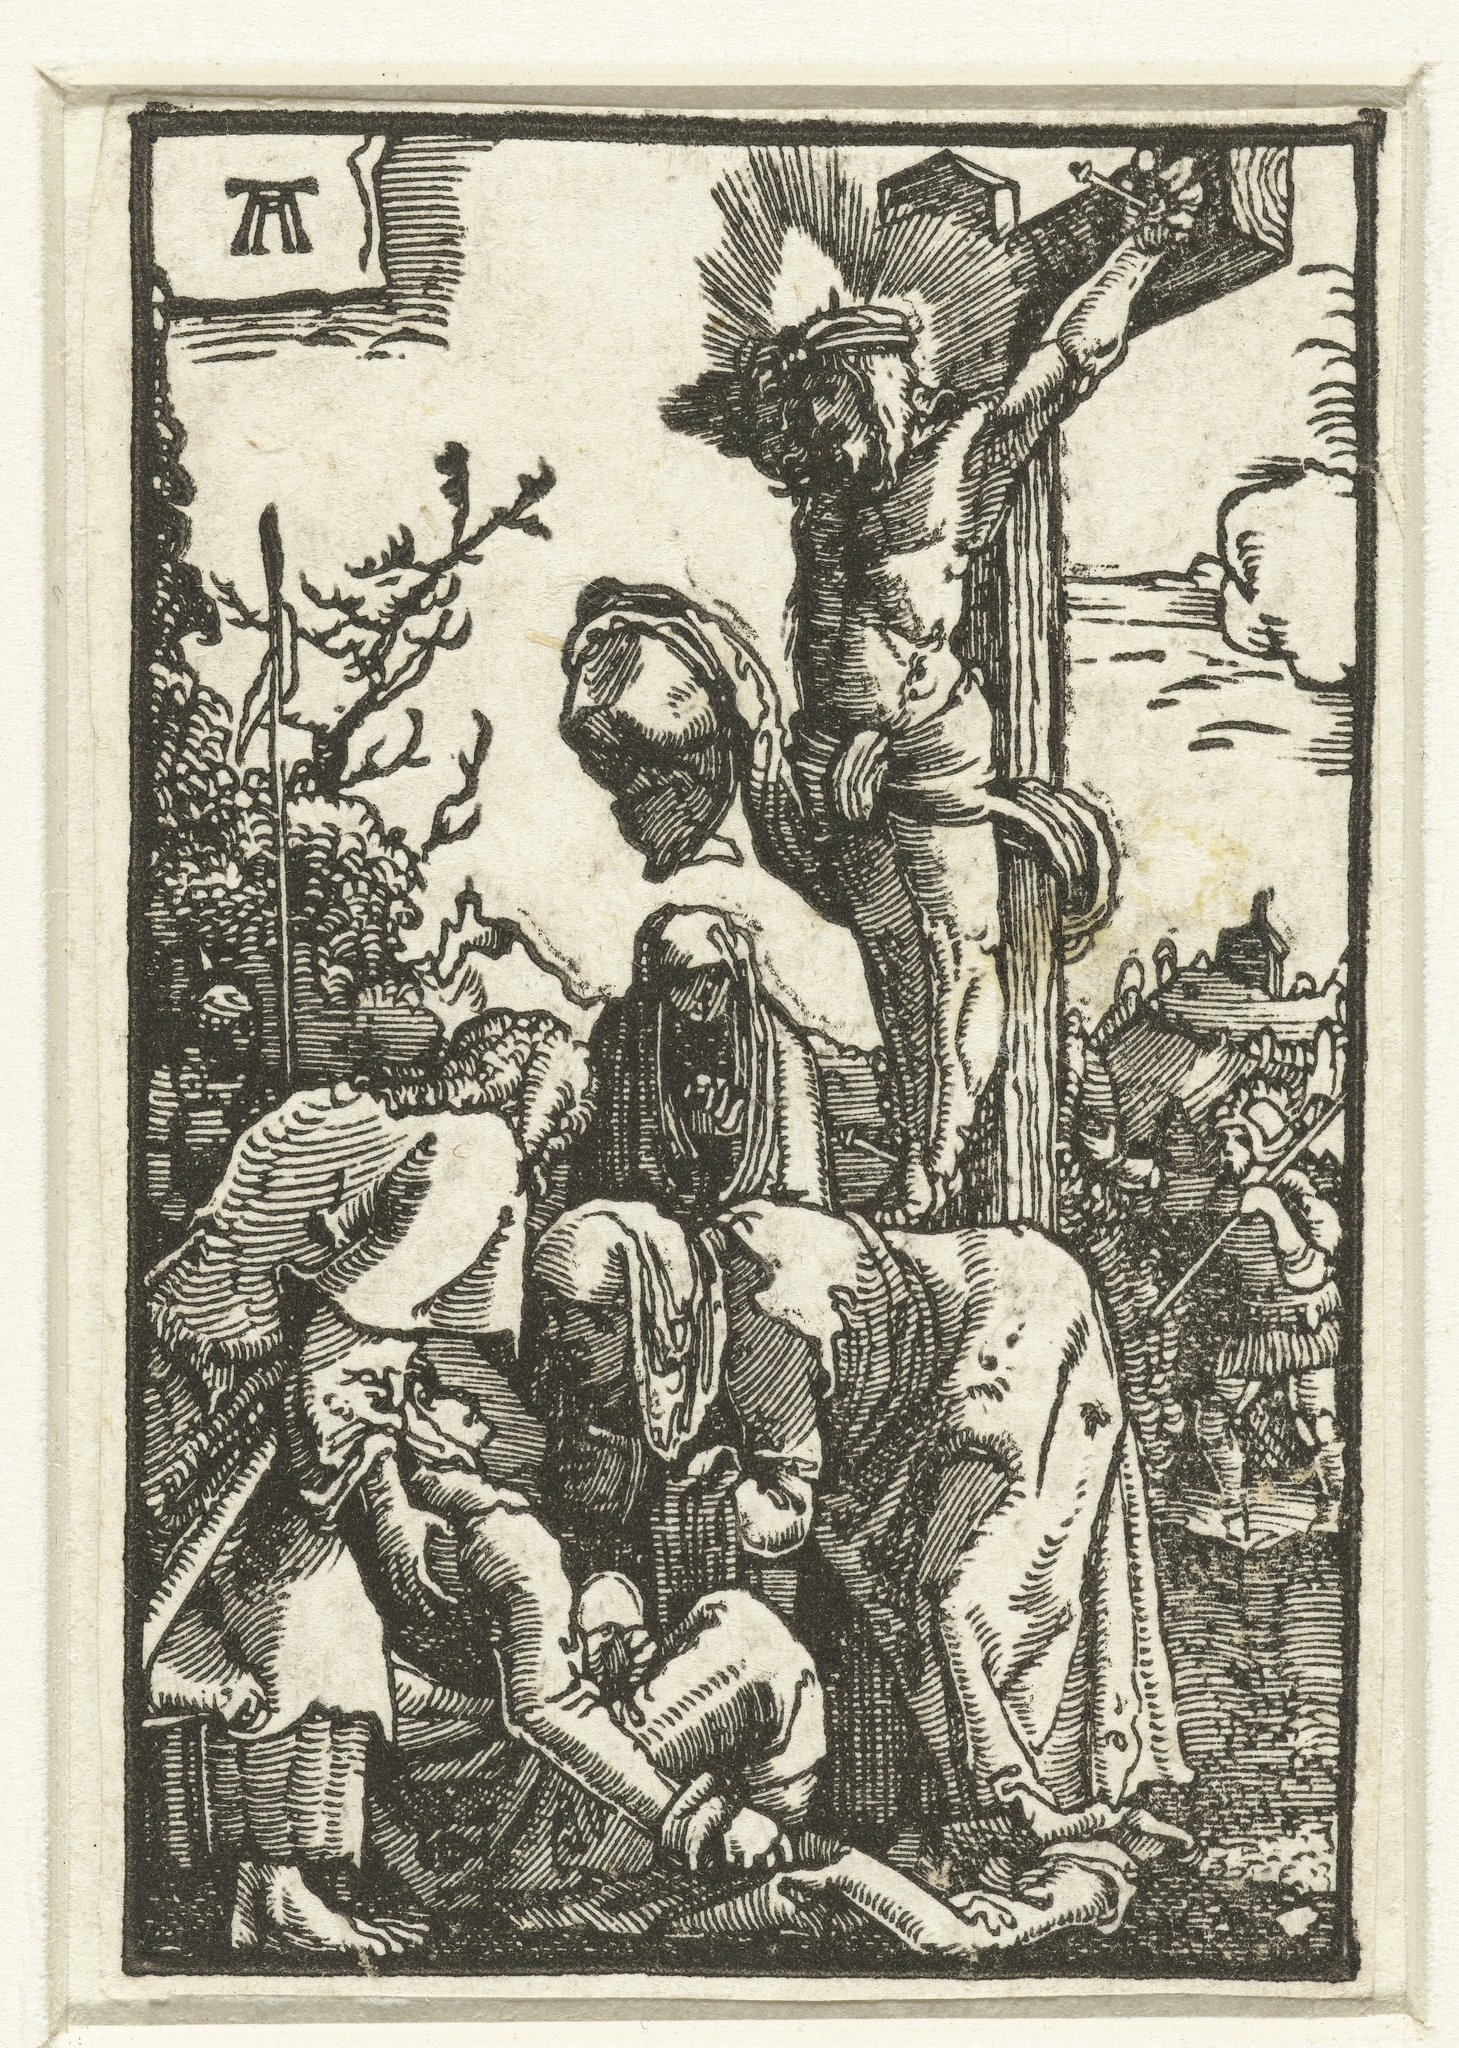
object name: print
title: De val en verlossing van de mensheid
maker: albrecht altdorfer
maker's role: draughtsman, print maker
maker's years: 1480-1538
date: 1506-1538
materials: paper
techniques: woodcut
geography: germany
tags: crucified christ with mary, john, and mary magdalene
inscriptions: number: ‘58’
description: Christus aan het kruis. Maria, aan de voet van het kruis, is bezweken. Zij wordt ondersteund door Johannes en Maria Magdalena. Dertigste prent uit een serie van veertig.